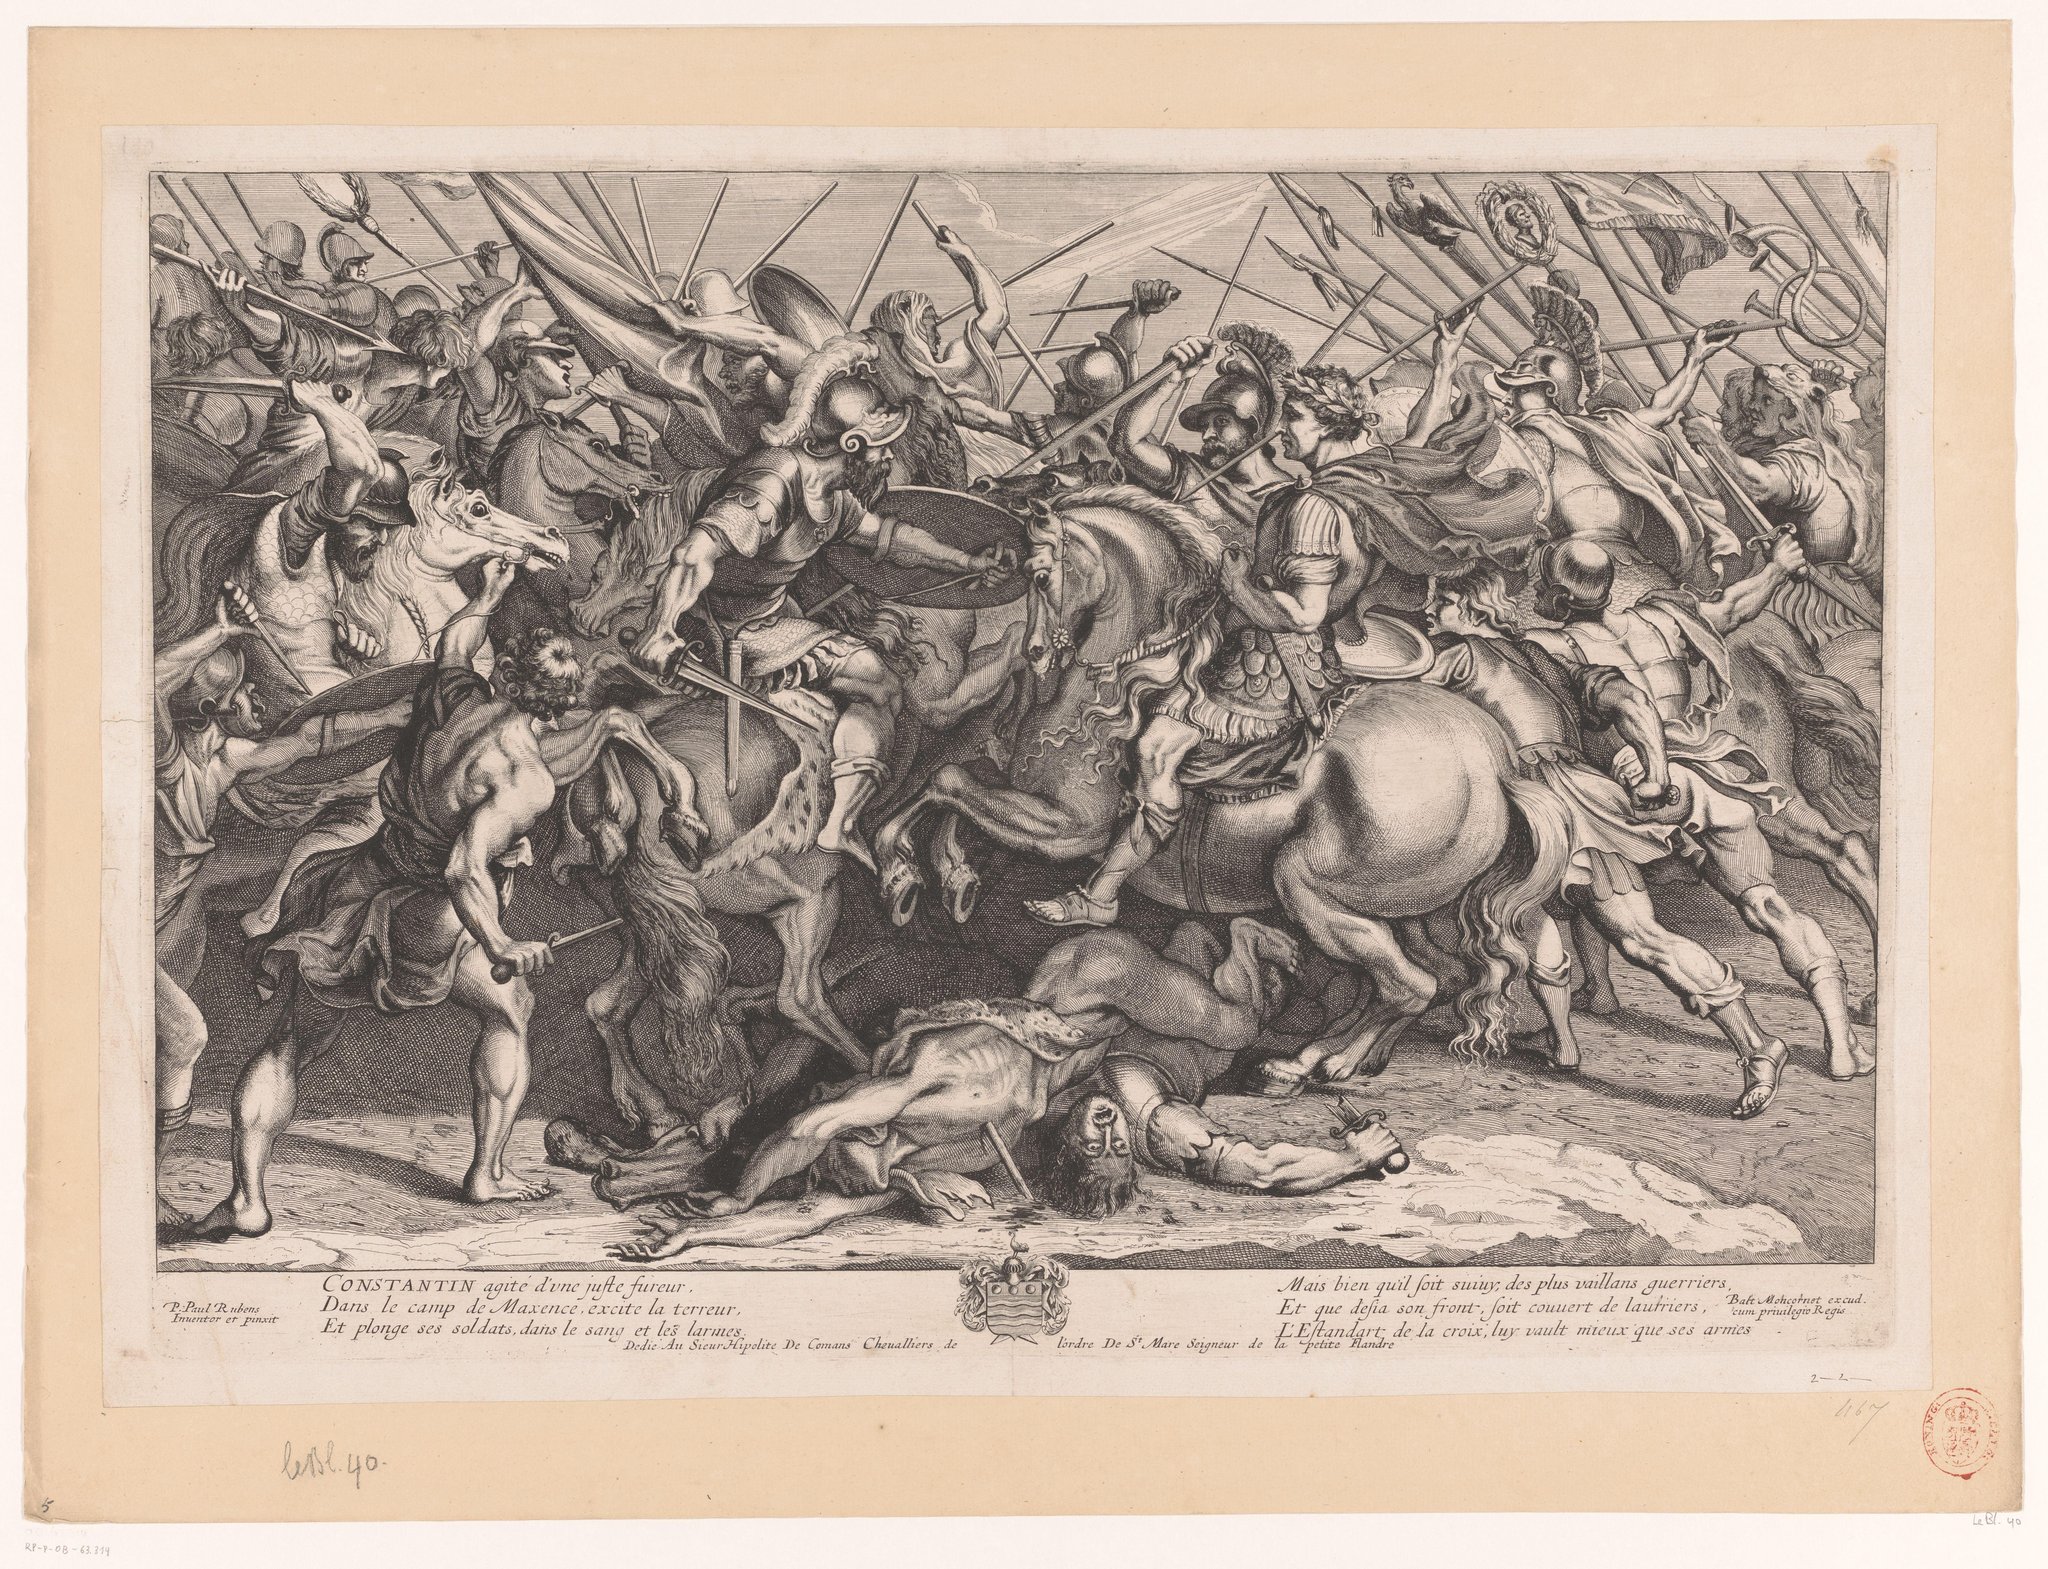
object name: print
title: Gevecht van Constantijn tegen Maxentius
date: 1610-1668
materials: paper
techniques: engraving, etching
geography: france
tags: historical persons, battle, fighting in general, armorial bearing, heraldry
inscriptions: collector's mark: Lugt 240